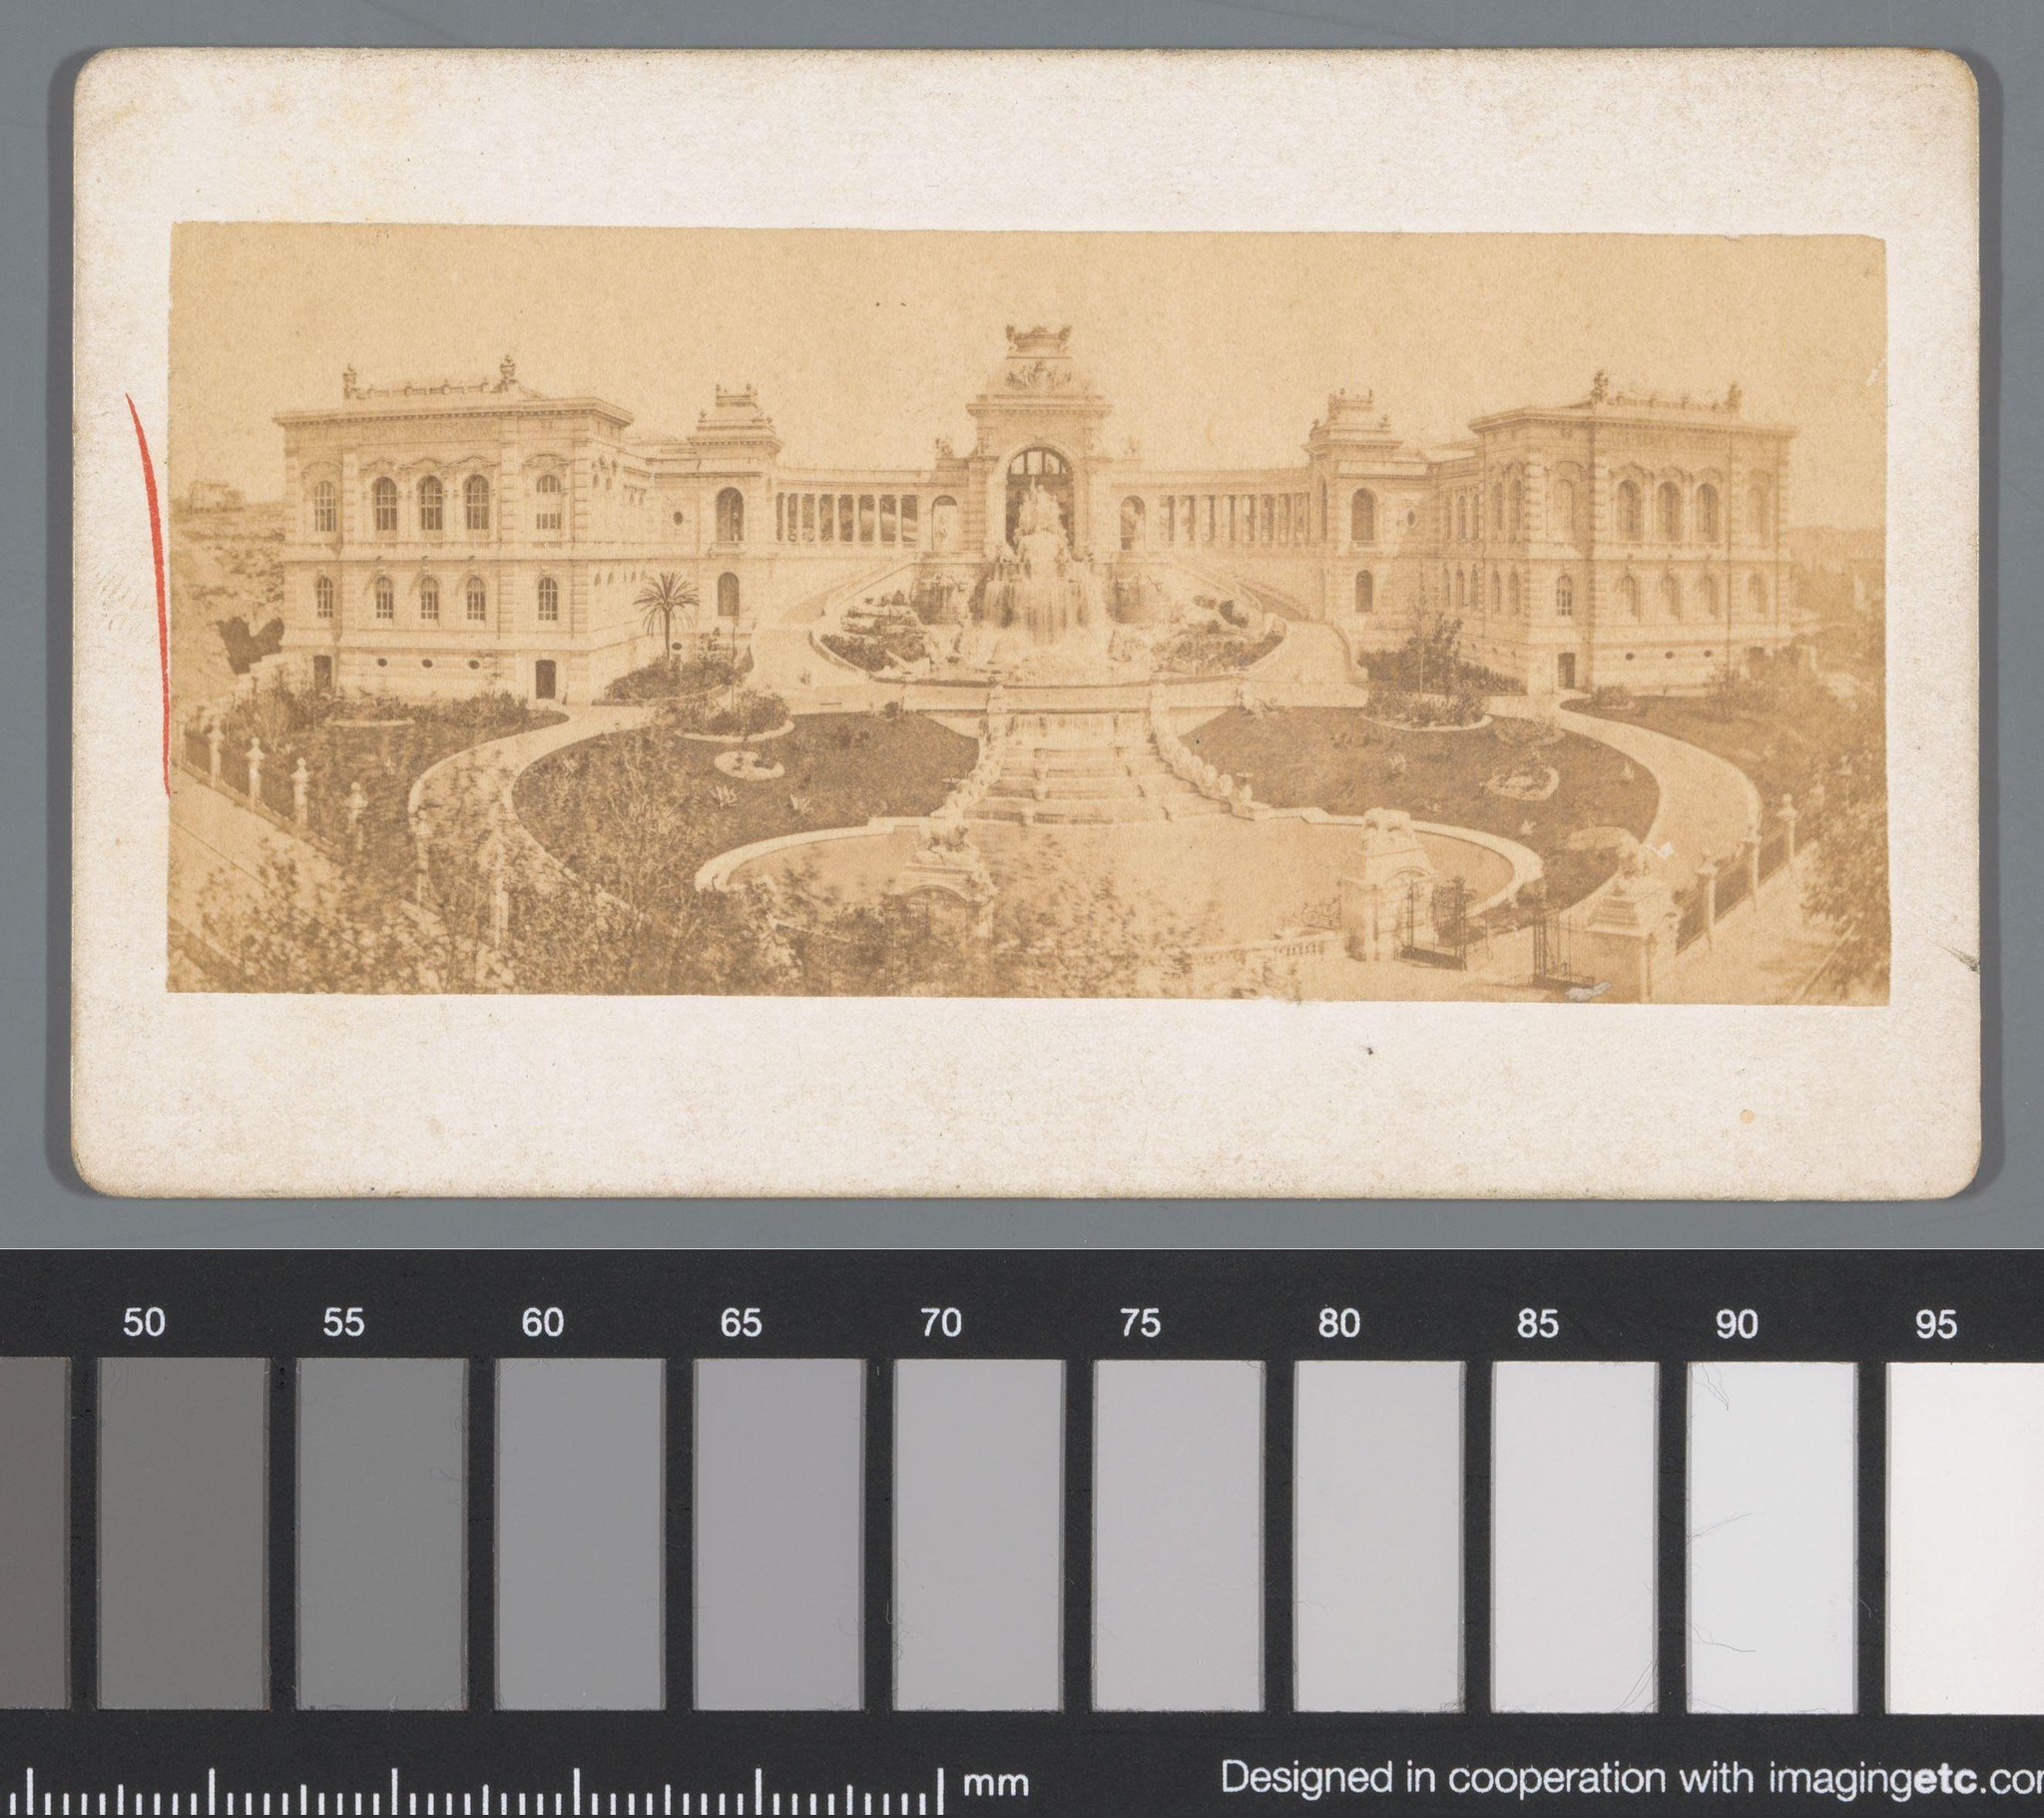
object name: photograph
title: Gezicht op Palais Longchamp in Marseille, Frankrijk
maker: melchioneur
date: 1872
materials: cardboard, paper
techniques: albumen print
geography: marseille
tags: palace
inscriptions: inscription: ‘Palais Long-Champ/ Musée des Beaux Arts/ Musée d'histoire naturelle/ Visité le G[...] / à 11 heures par un temps/ [...]’, inscription: ‘Melchioneur/ 14. Rue St. FERRÉOL, MARSEILLE/ LES CLICHÉS SONT CONSERVÉS/ Pour une nouvelle Commande/ rappeler le No.....’